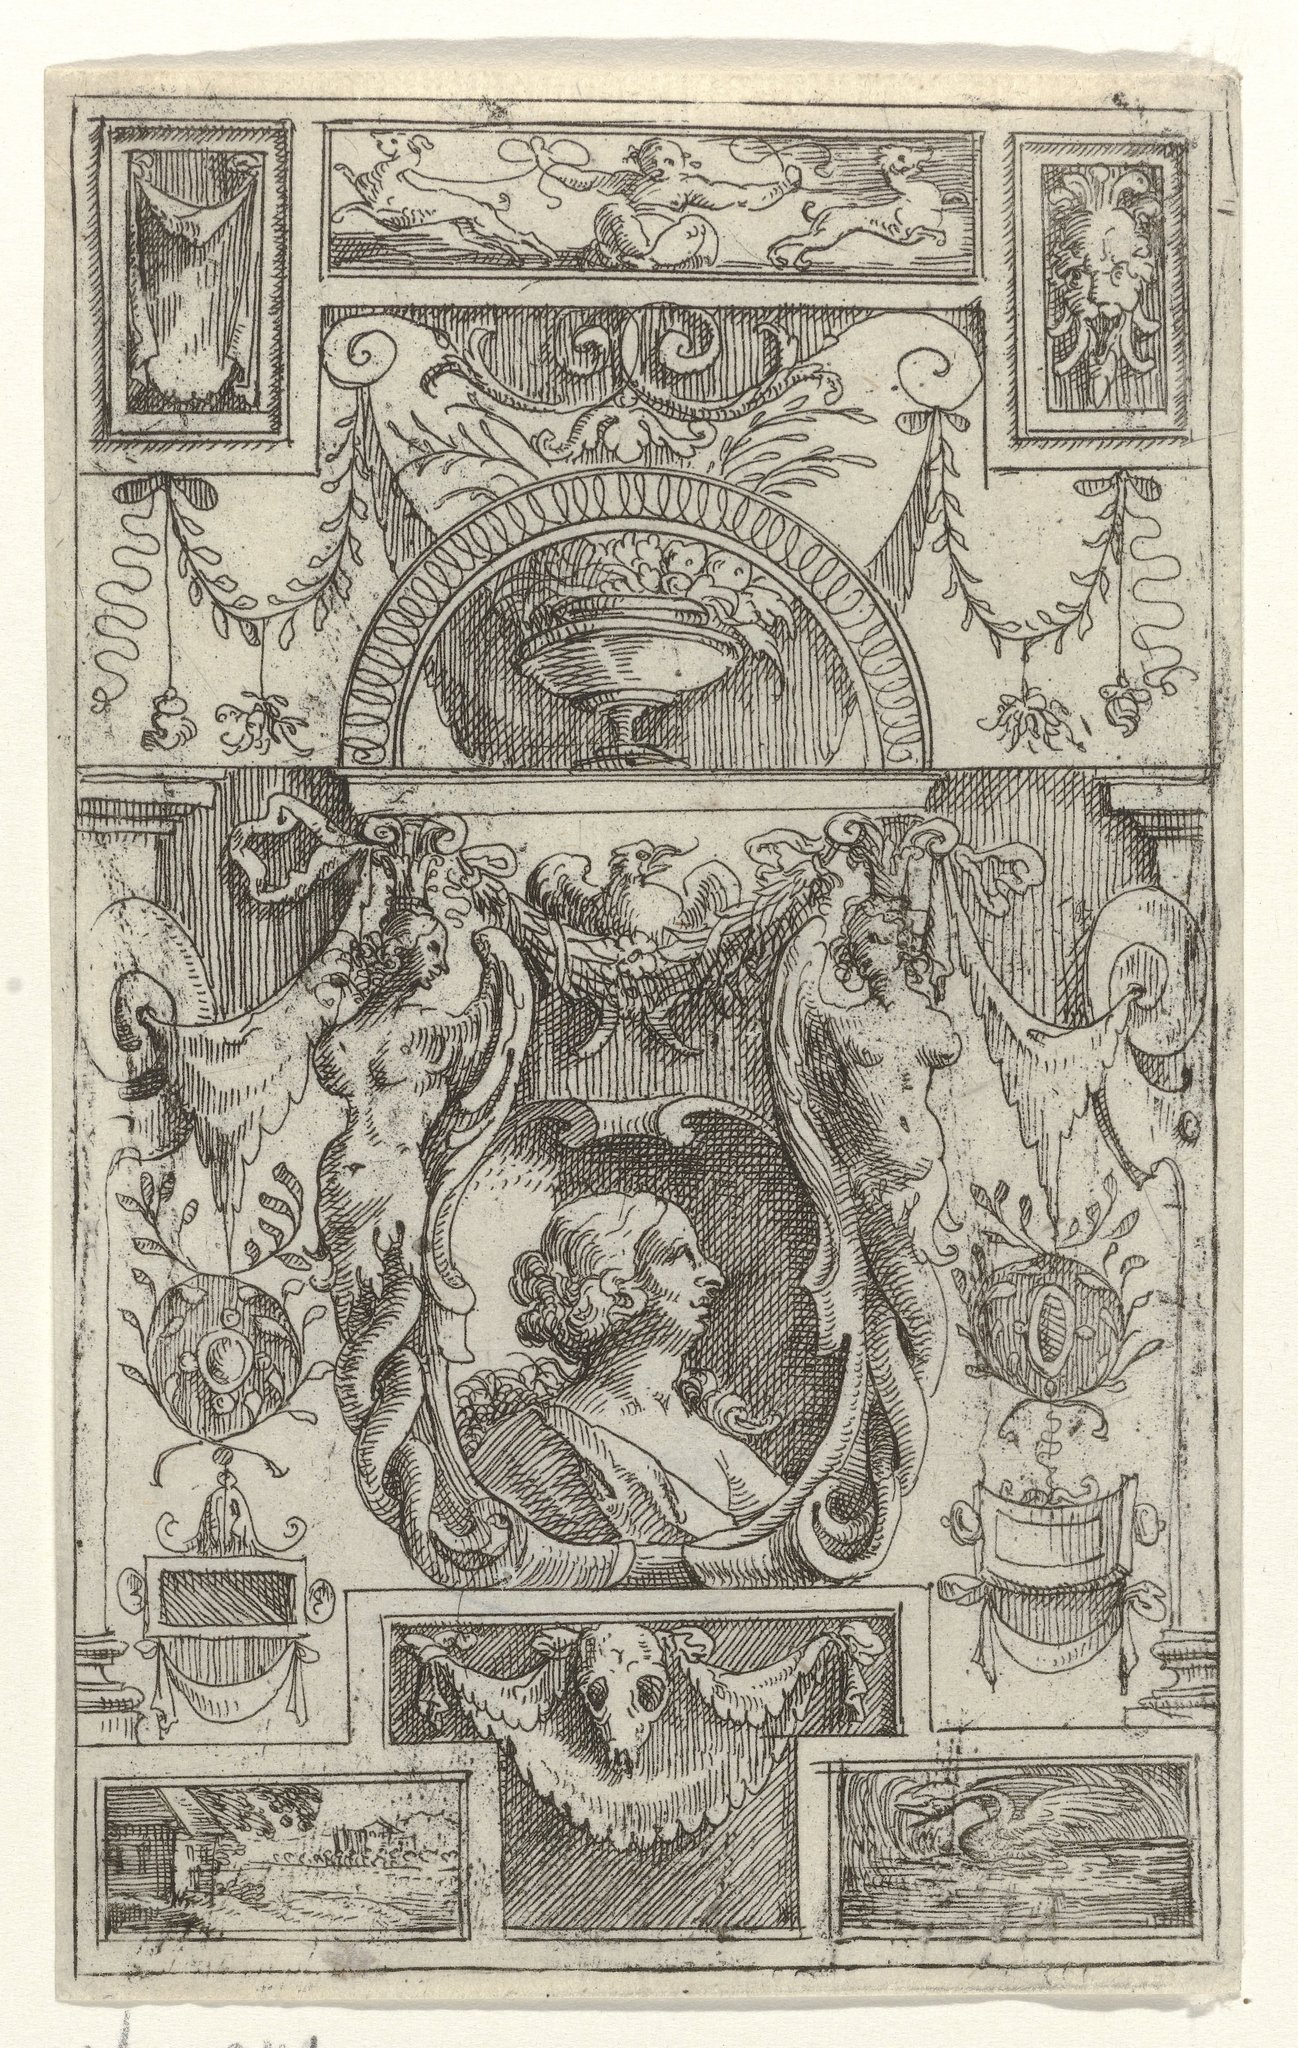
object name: ornament print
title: Paneel met vrouwenbuste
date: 1647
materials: paper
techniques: etching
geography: london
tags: ornament ~ grotesque, vase ~ ornament, chest, bust - aa - female human figure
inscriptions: collector's mark: Lugt 2228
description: Een paneel met grotesken. Twee termen flankeren een vrouwenbuste in het midden. Daarboven een vaas. Rondom diverse afbeeldingen van landschappen, maskers en dieren.